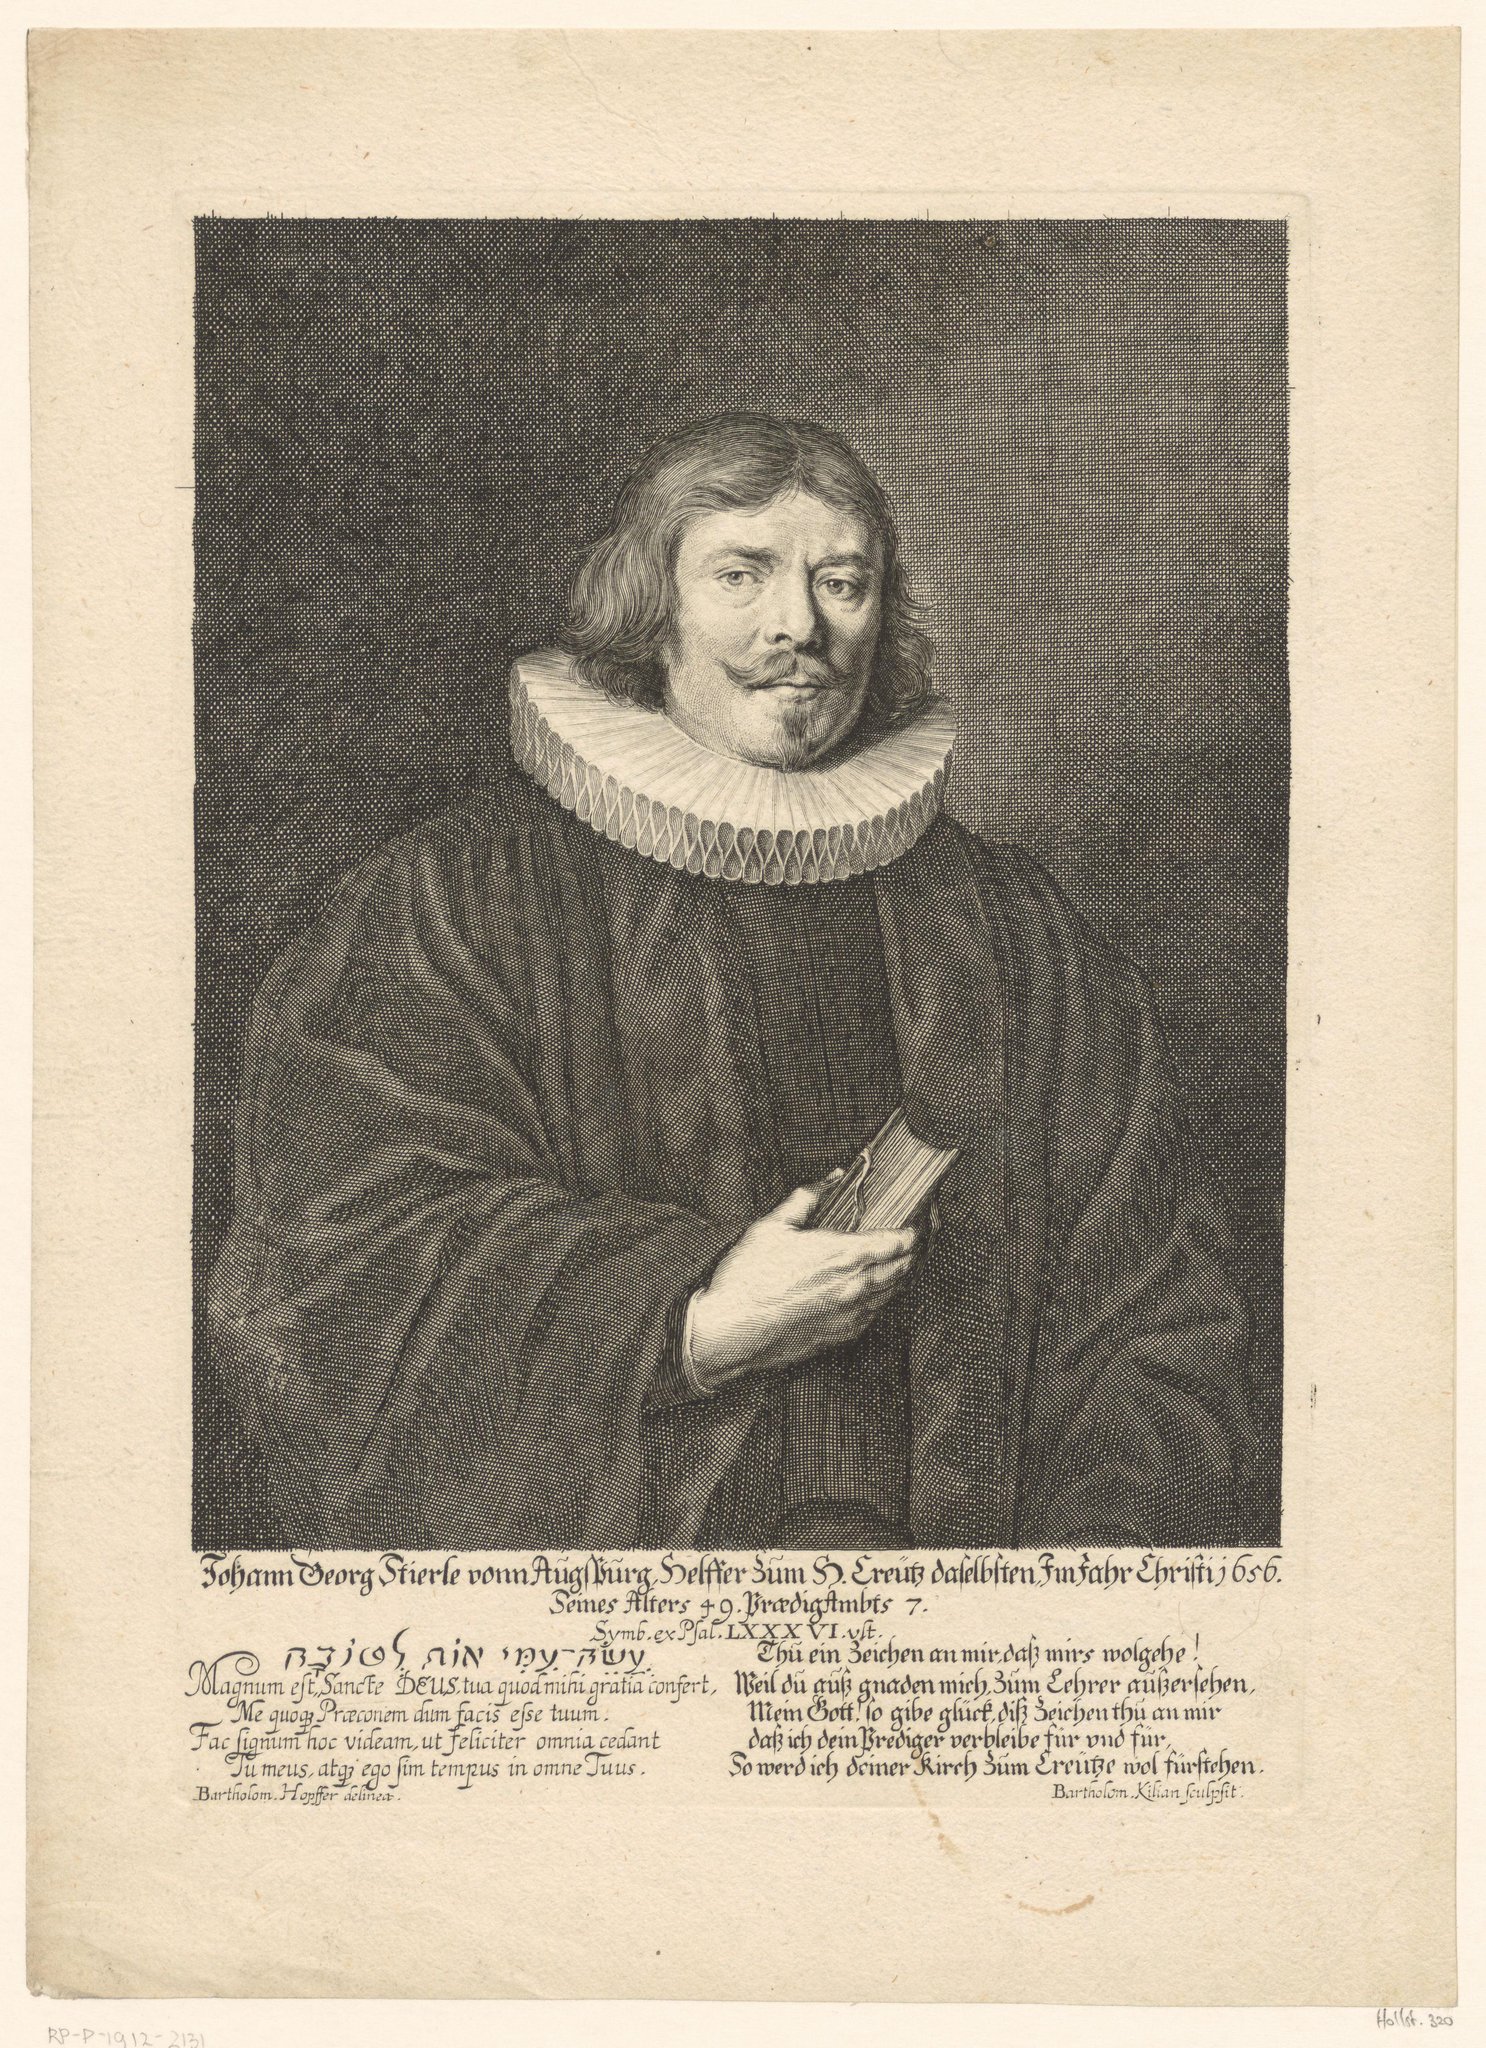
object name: print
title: Portret van Johann Georg Stierle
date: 1656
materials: paper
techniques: engraving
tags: augsburg, theologian, historical persons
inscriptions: collector's mark: Lugt 2228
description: Regels uit Psalm 86 in het Latijn en Duits in de marge, daarboven informatie over geportretteerde in het Duits.